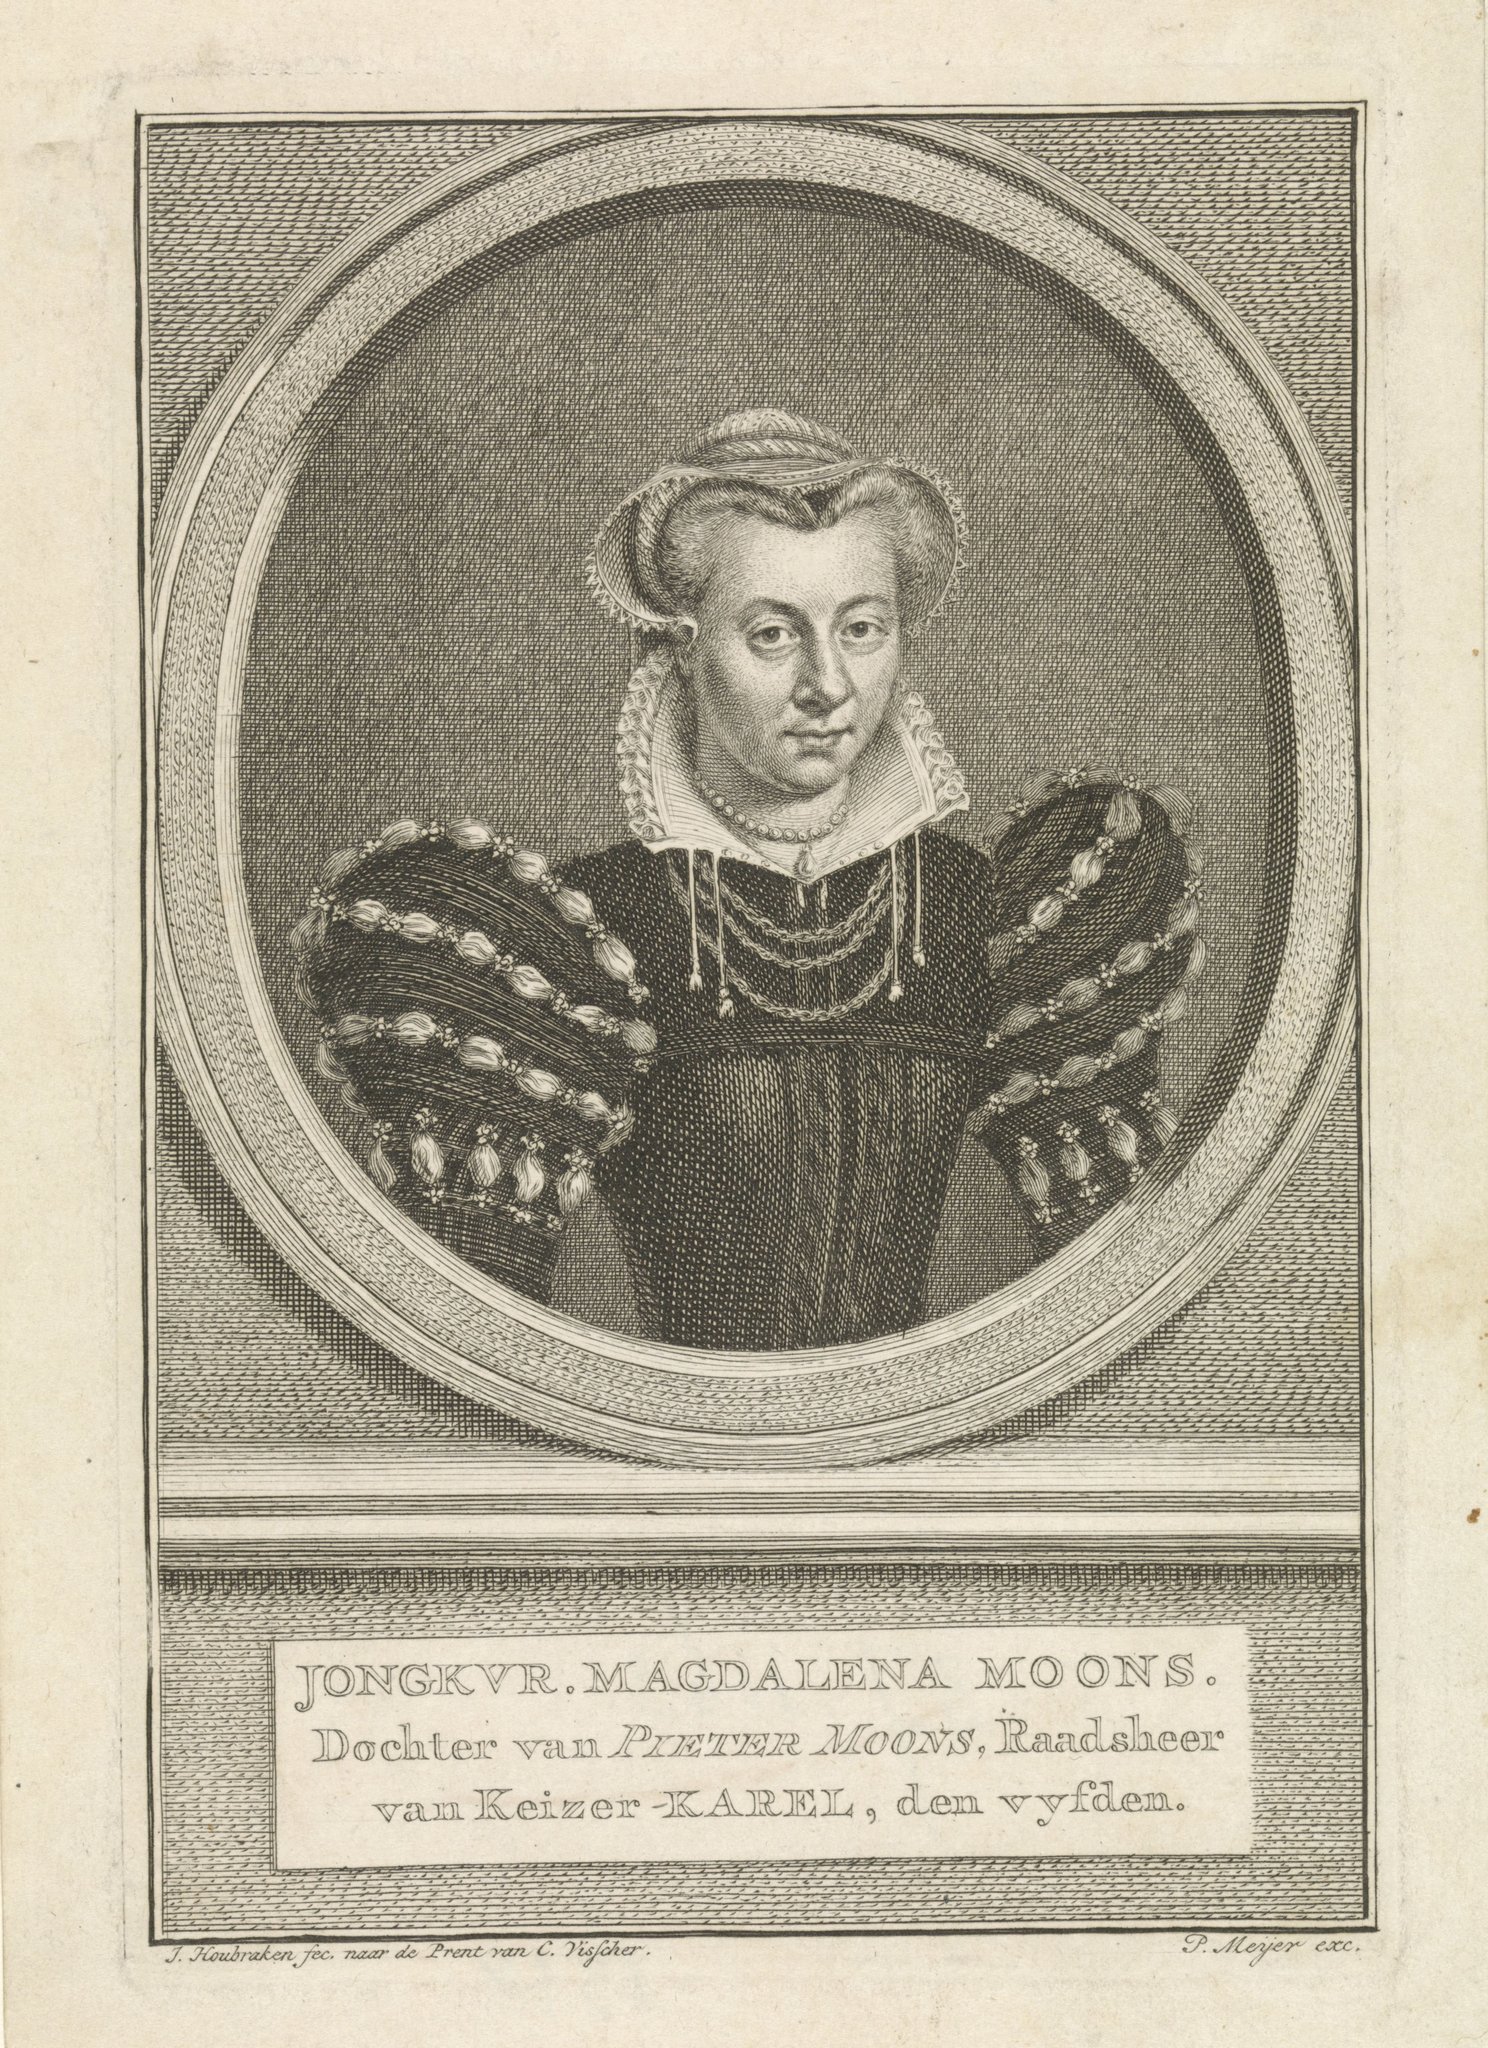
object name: print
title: Jongkvr. Magdalena Moons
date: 1774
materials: paper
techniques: engraving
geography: amsterdam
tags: the hague, utrecht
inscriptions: collector's mark: Lugt 2228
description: Prent volgens Ver Huell ook gebruikt in: Lucretia Wilhelmina van Winter geboren van Merken, Het beleg der stad Leyden. Treurspel. Amsterdam: Pieter Meijer, 1774.